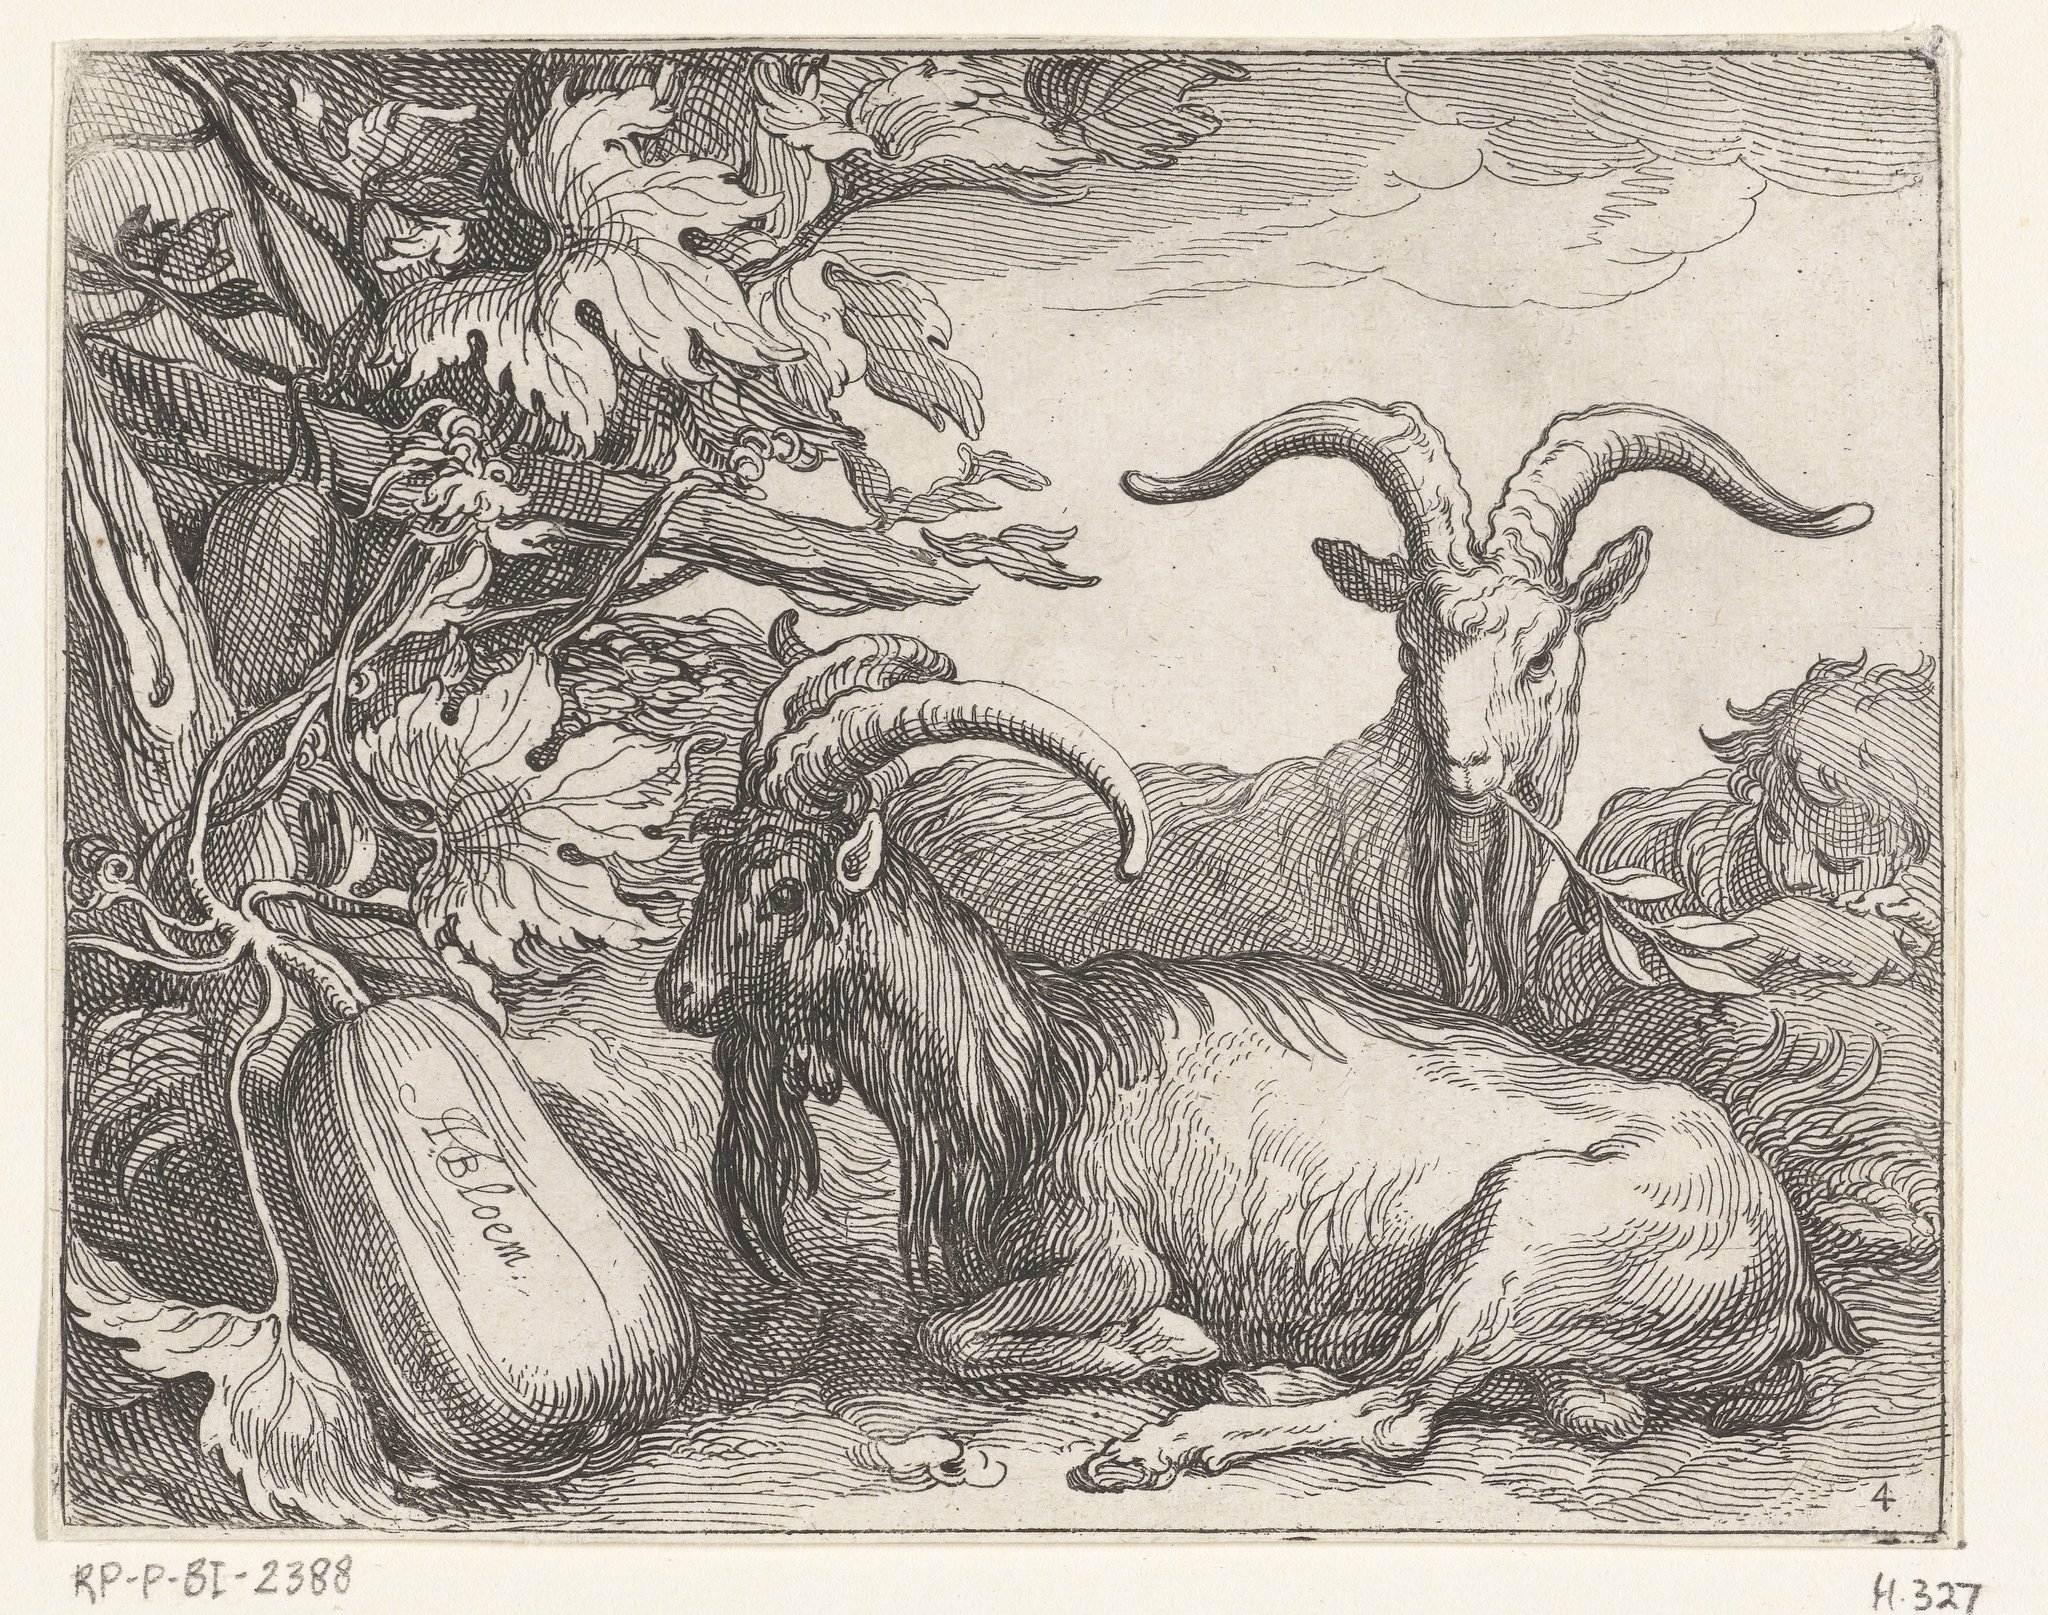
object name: print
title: Geiten en kalebas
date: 1611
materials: paper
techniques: etching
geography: amsterdam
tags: fruits: melon, goat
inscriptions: collector's mark: Lugt 240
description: Prent uit serie met veertien prenten zogenaamde Pastoralen naar ontwerp van Abraham Bloemaert.